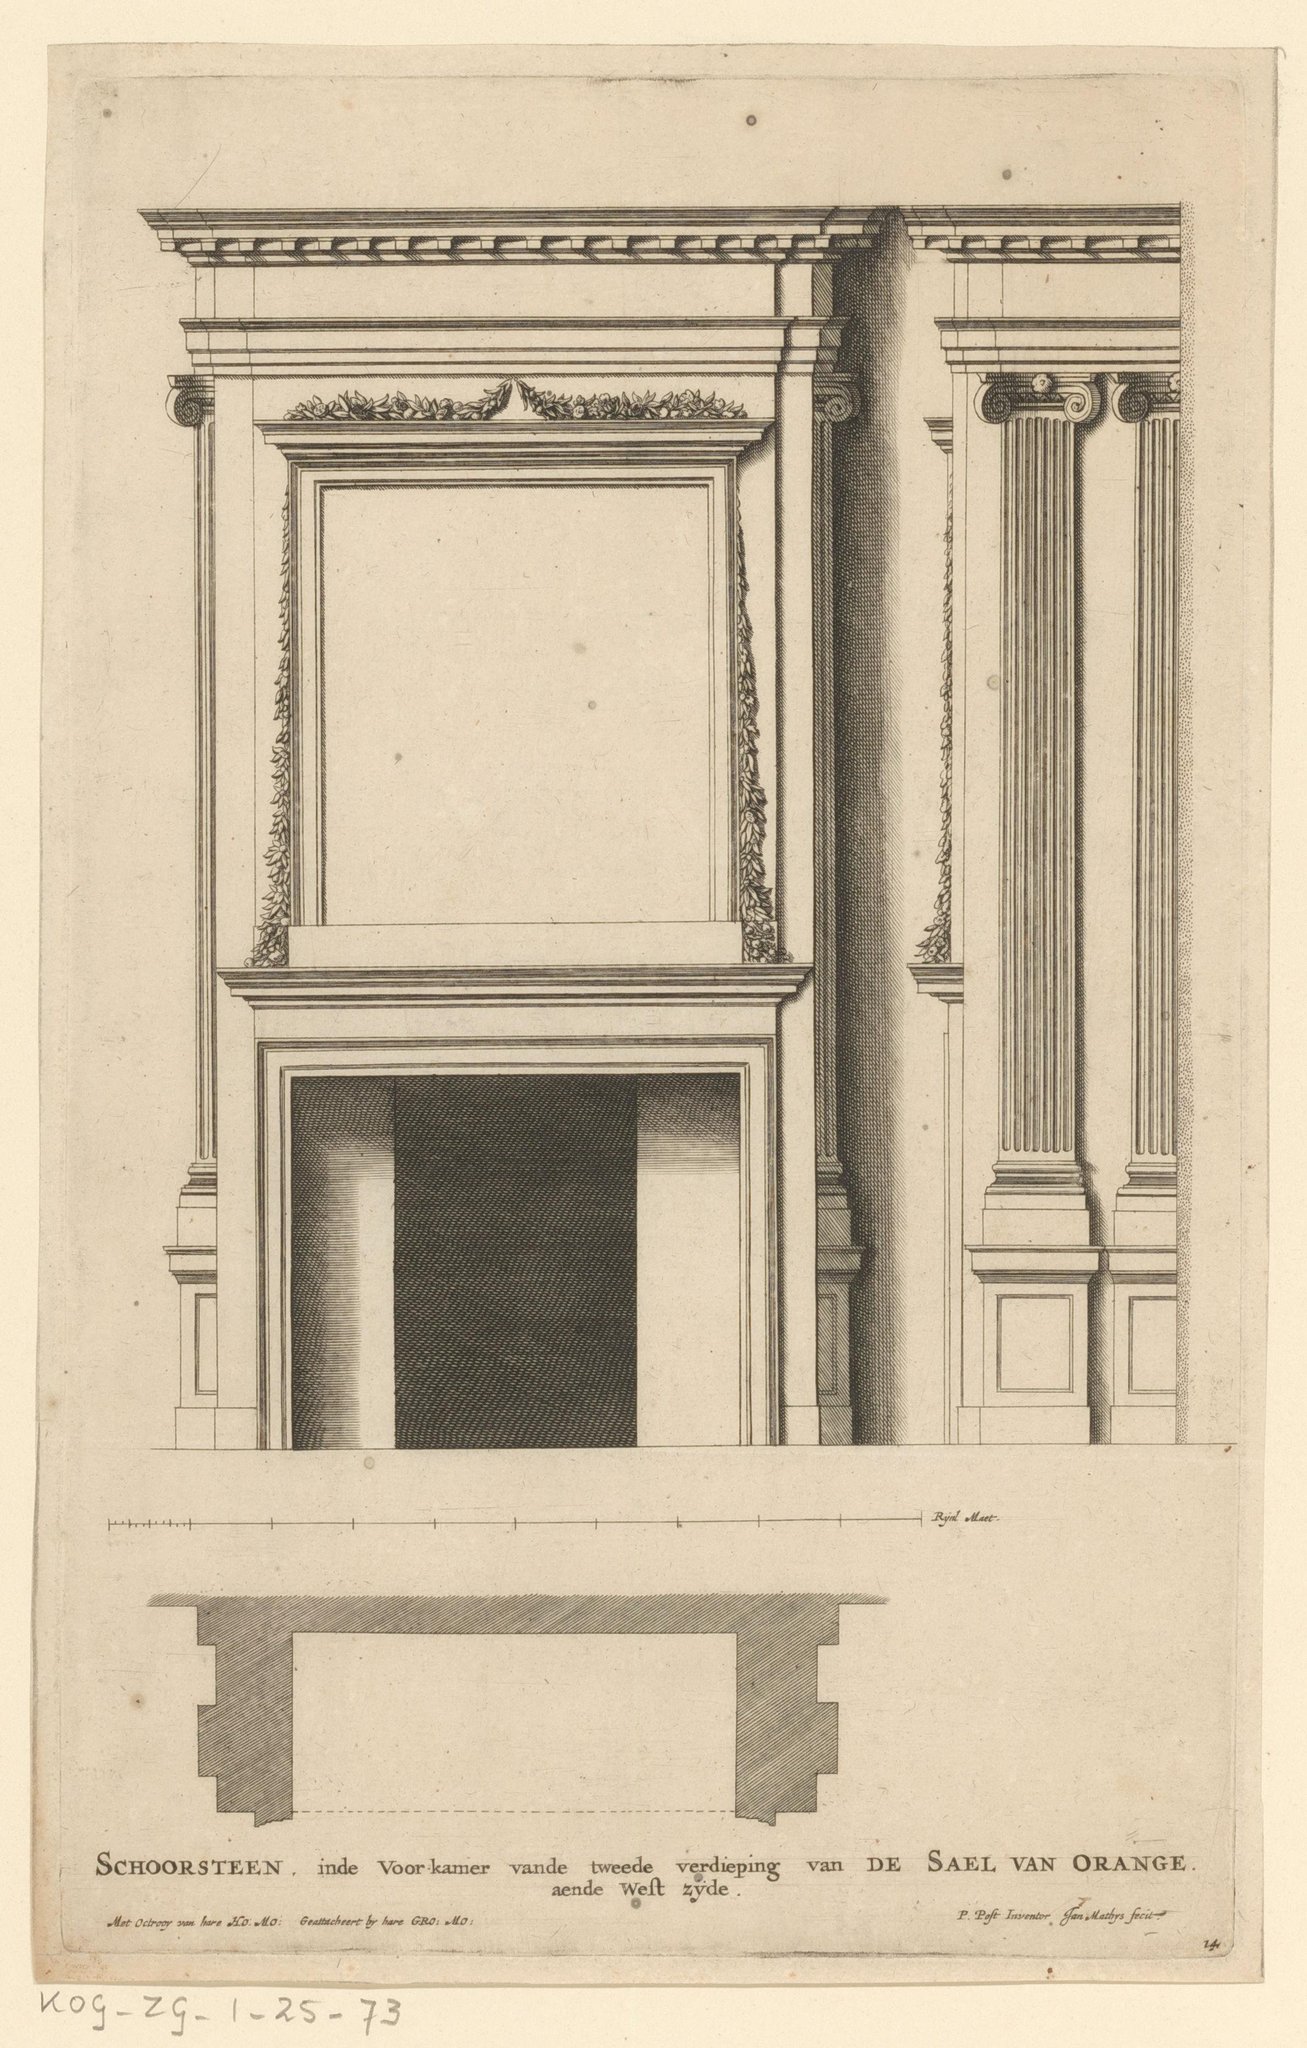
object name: print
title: Voor- en zijgezicht van een schouw van de tweede verdieping van Paleis Huis ten Bosch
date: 1669-1706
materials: paper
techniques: engraving, etching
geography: amsterdam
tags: chimney, chimney ornaments, chimney-piece, mantelpiece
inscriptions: collector's mark: Lugt 1641a, : ‘Met Octrooy van hare HO: MO: Geattacheert bij hare GRO: MO:’, stamp:, stamp:, collector's mark: Lugt 1641, stamp:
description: Titelprent is onderdeel van een serie bestaande uit een titelprent en 22 vervolg prenten. De serie is voor het eerst uitgegeven door Pieter Jansz. Post in Den Haag of Rotterdam. De huidige (tweede staat) is uitgegeven door Frederik de Wit tussen 1669 en 1706. De volgorde van de prenten is in deze serie veranderd. De prenten zijn een derde keer uitgegeven door Pieter van der Aa in 1715 te Leiden. Hier is de volgorde wederom aangepast.